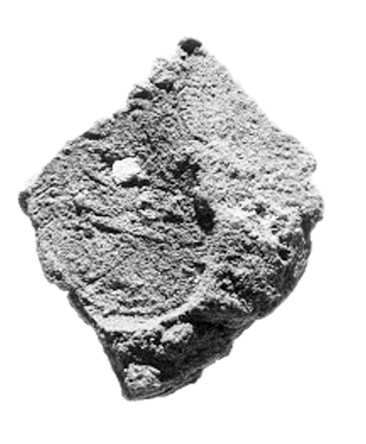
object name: sealing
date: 1981-1640 BCE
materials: mud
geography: egypt